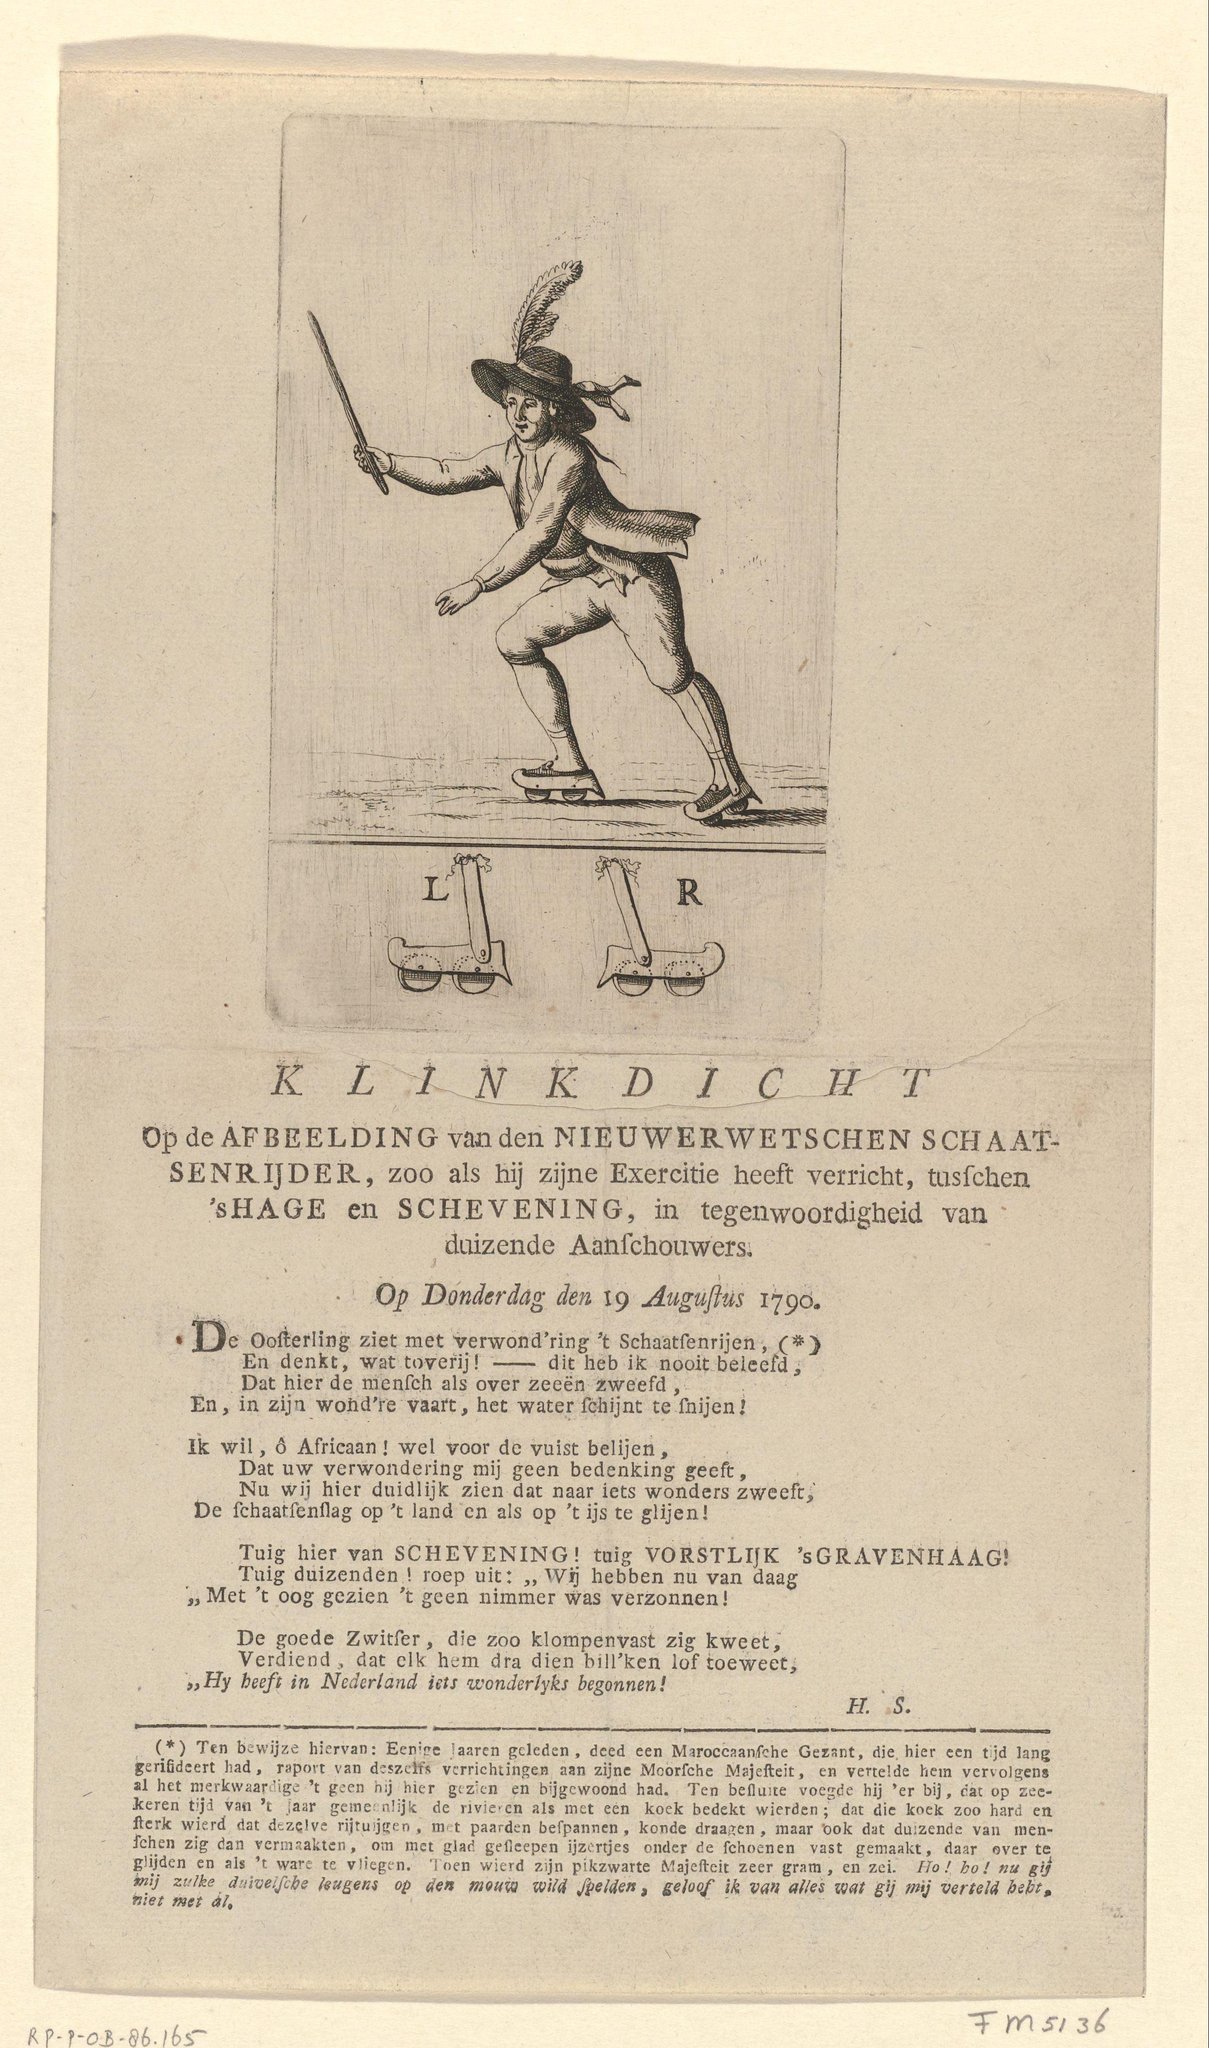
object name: print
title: Rolschaatser, 1790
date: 1790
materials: paper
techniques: etching, letterpress printing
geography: northern netherlands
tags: roller-skating, roller-skates, the hague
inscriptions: collector's mark: Lugt 2228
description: De Zwitserse rolschaatser die op 19 augustus 1790 een demonstratie van het rolschaatsen gaf, op de weg tussen Den Haag en Scheveningen. Met details van de linker en rechter rolschaats. Op het blad onder de plaat een klinkdicht in vier coupletten en in een voetnoot een verhaal over de Marokkaanse gezant.